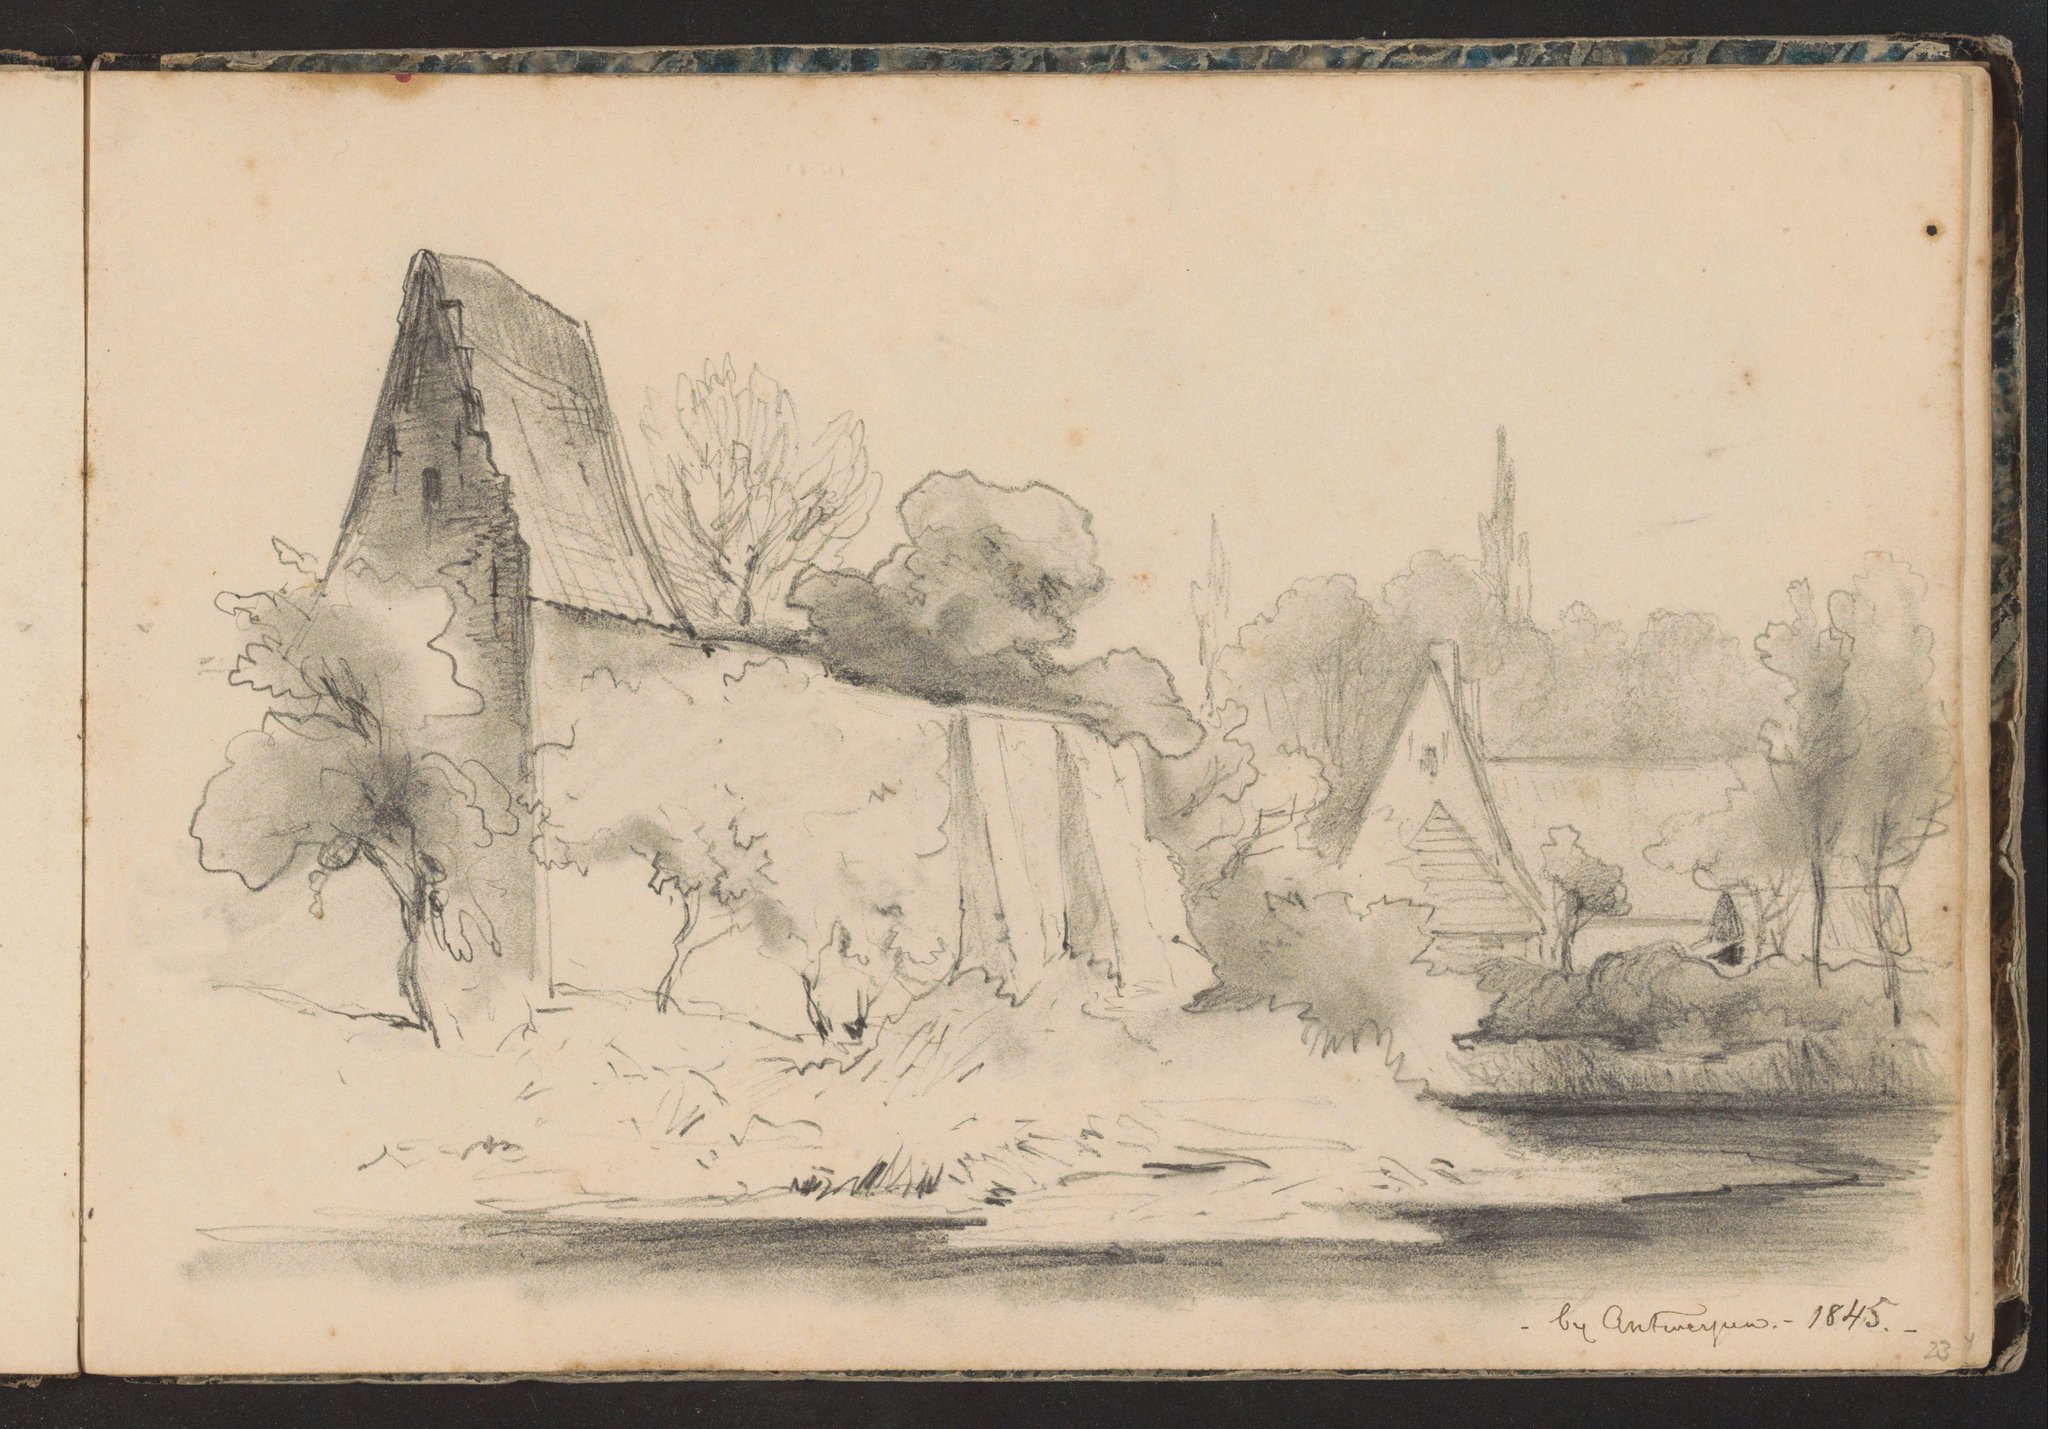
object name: sketchbook leaf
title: Huizen aan het water bij Antwerpen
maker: johannes tavenraat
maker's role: draughtsman, painter, print maker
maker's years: 1809-1881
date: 1845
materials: paper, pencil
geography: antwerp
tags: city-view, and landscape with man-made constructions, landscapes with waters, waterscapes, seascapes (in the temperate zone), antwerp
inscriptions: date and inscription: ‘bij Antwerpen - 1845-’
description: Blad 23 recto uit een schetsboek met 44 bladen.